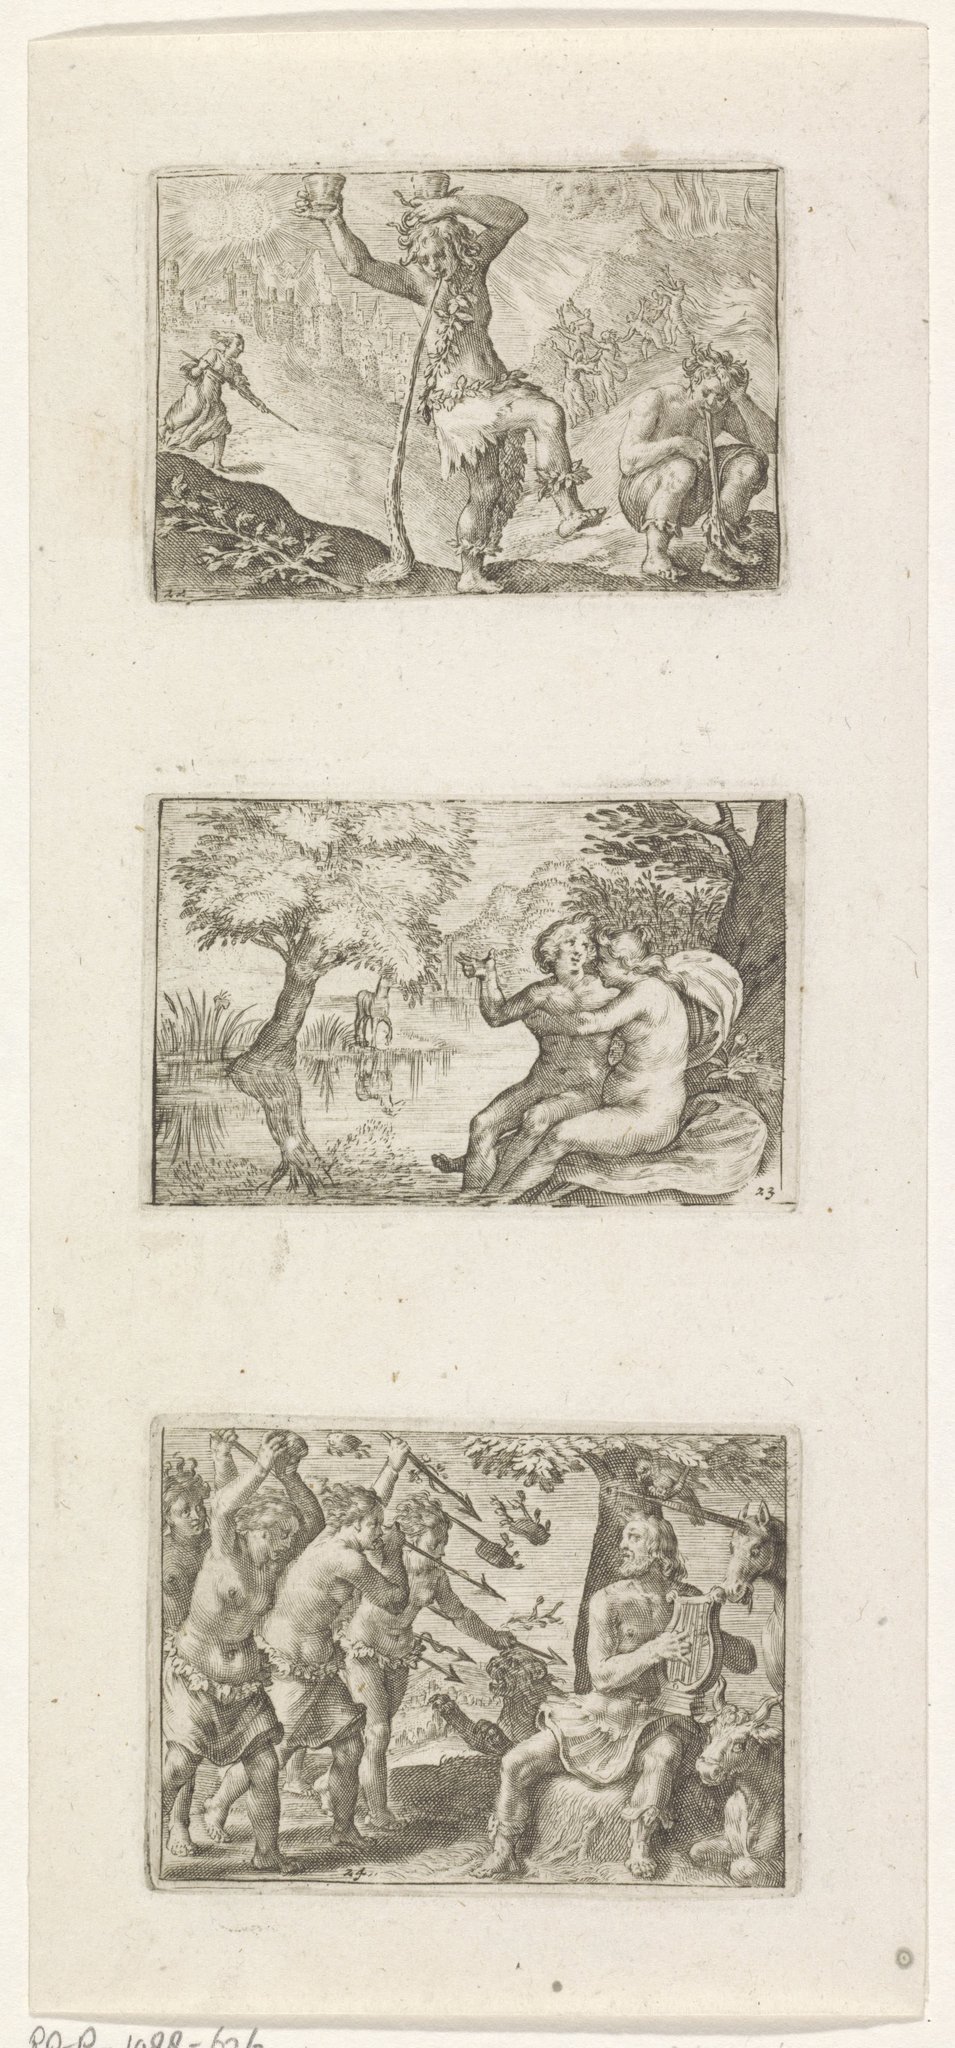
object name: print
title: Mythologische en allegorische voorstellingen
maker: monogrammist mp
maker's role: print maker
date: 1680-1800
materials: paper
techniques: engraving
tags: orpheus playing the lyre: trees and rocks move, beasts and birds are enchanted, thiasos, i.e. bacchus' revel-rout, bacchanal without bacchus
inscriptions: collector's mark: Lugt 2228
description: Drie voorstellingen op een blad. Boven: Twee dronken saters. Midden: Twee geliefden aan de waterkant. Onder: Orpheus betovert de dieren met zijn spel op de lier. Bacchanten belagen hem met pijlen.